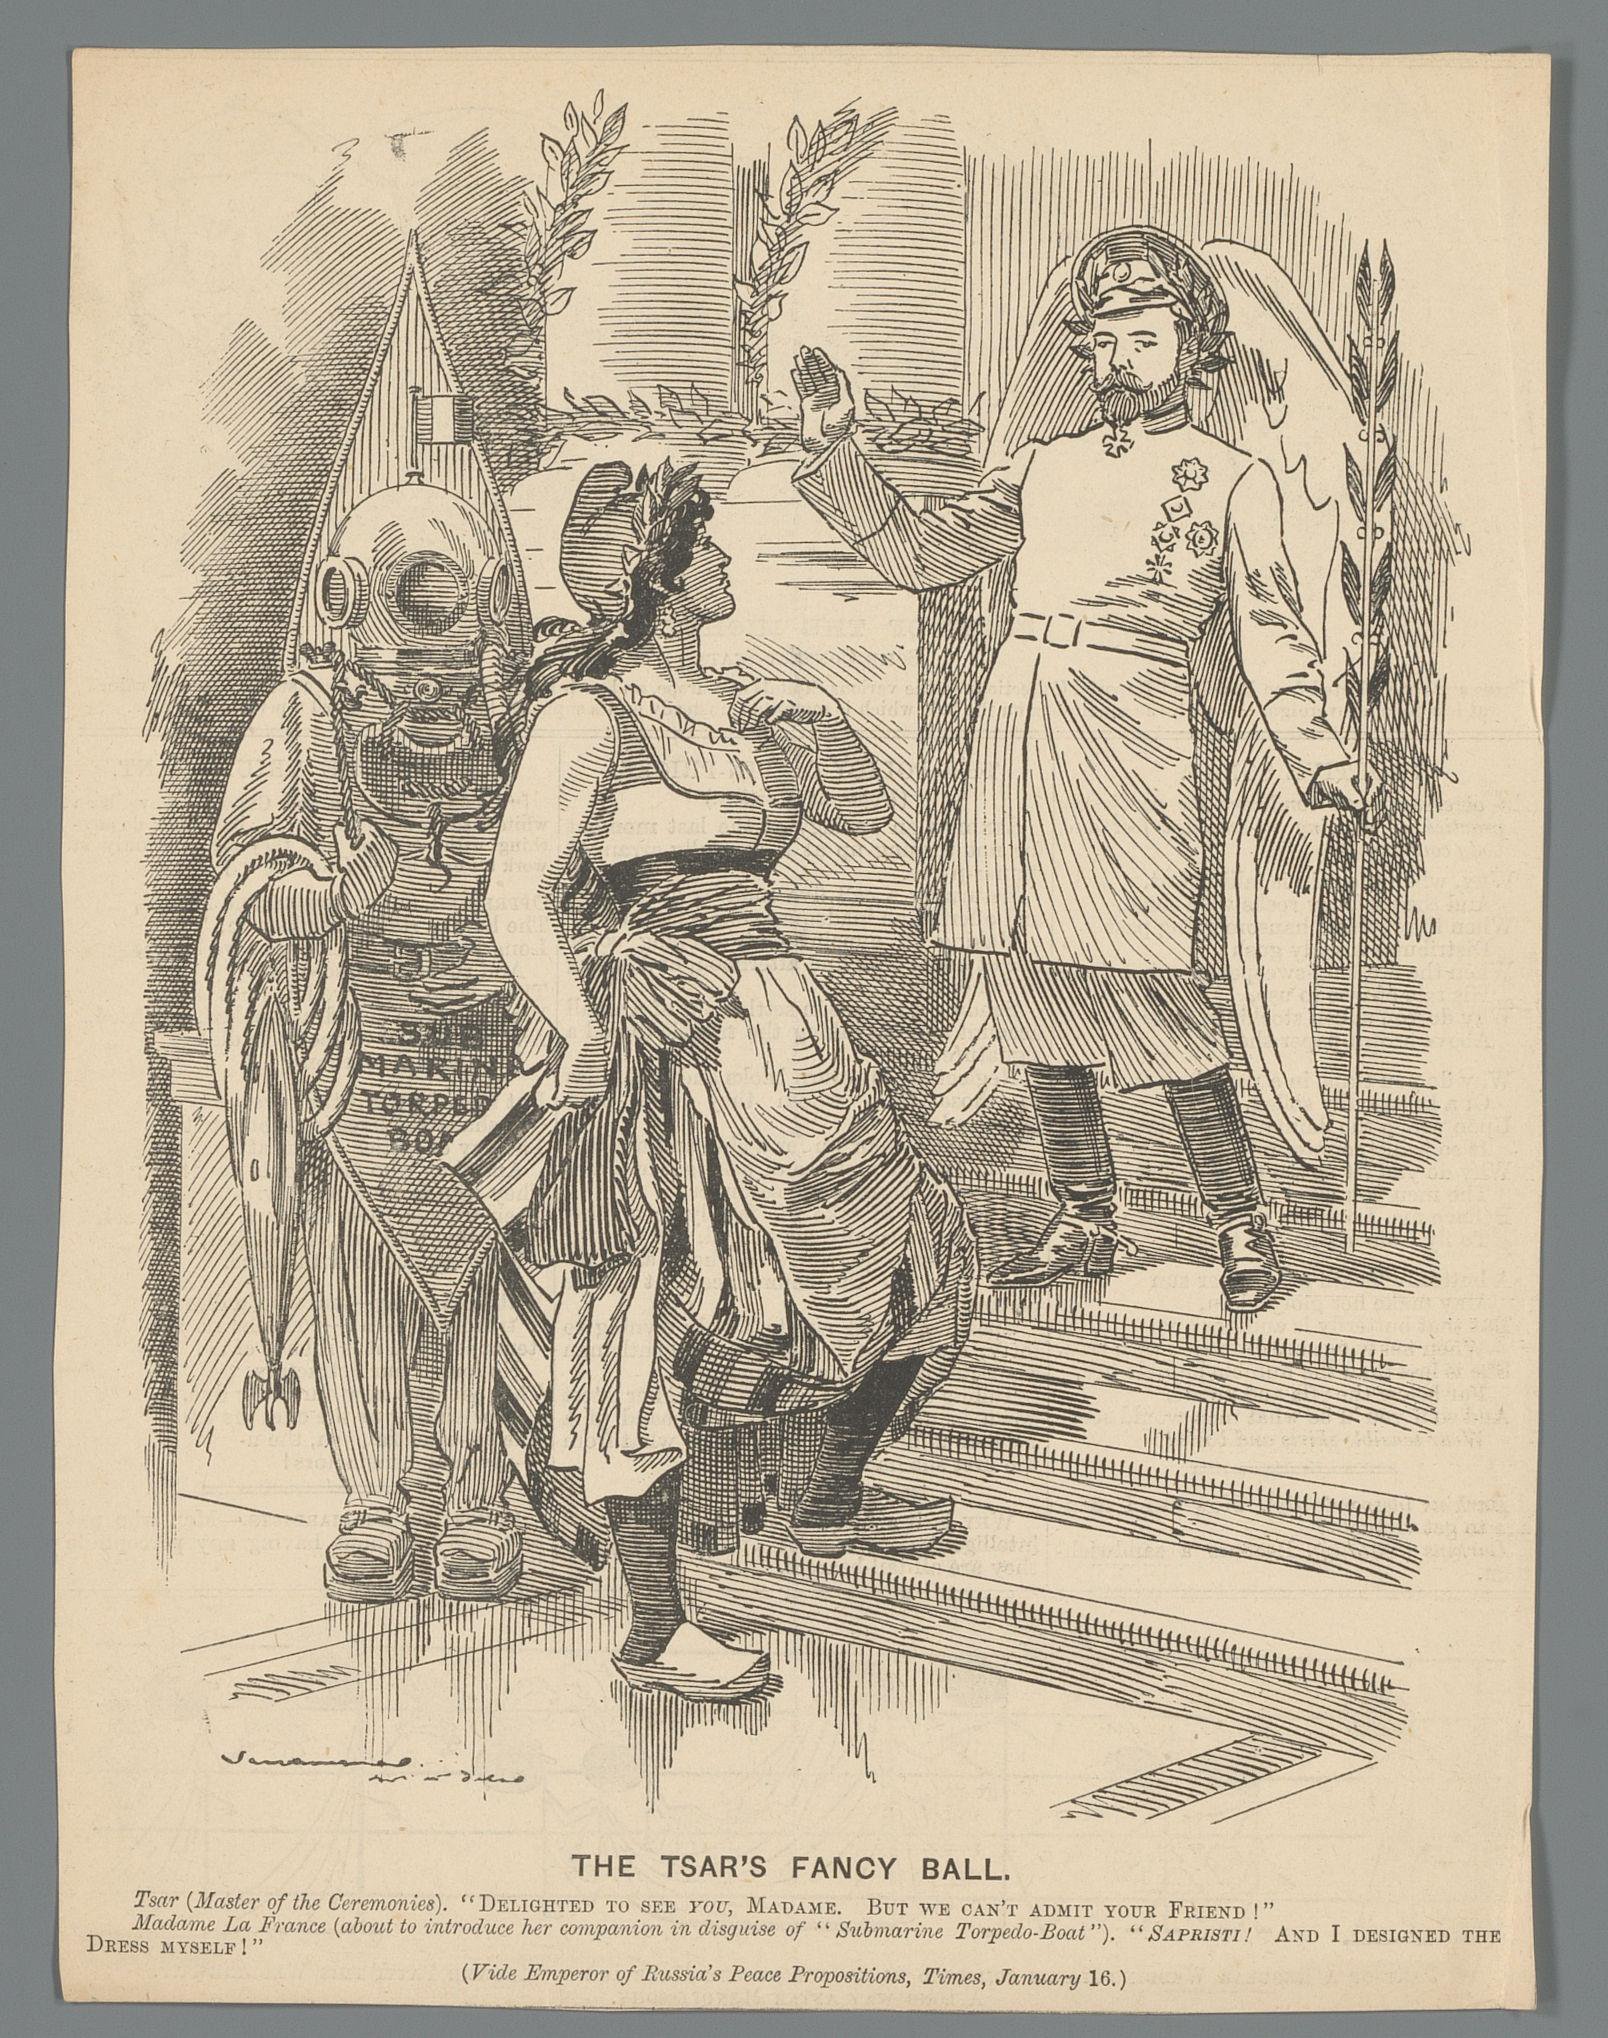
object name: cartoon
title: Tsaar Nicolaas II en Frankrijk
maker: edward linley sambourne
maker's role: draughtsman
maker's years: 1844-1910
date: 1899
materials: paper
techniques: line block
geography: england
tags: personifications of countries, nations, states, districts, etc., deep-sea diving, political caricatures and satires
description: Tsaar Nicolaas II van Rusland als portier wil wel de Franse maagd maar niet haar partner de diepzeeduiker (onderzee torpedoboot) toelaten tot het bal. Politieke spotprent uit het Engelse satirische tijdschrift Punch, 1899.